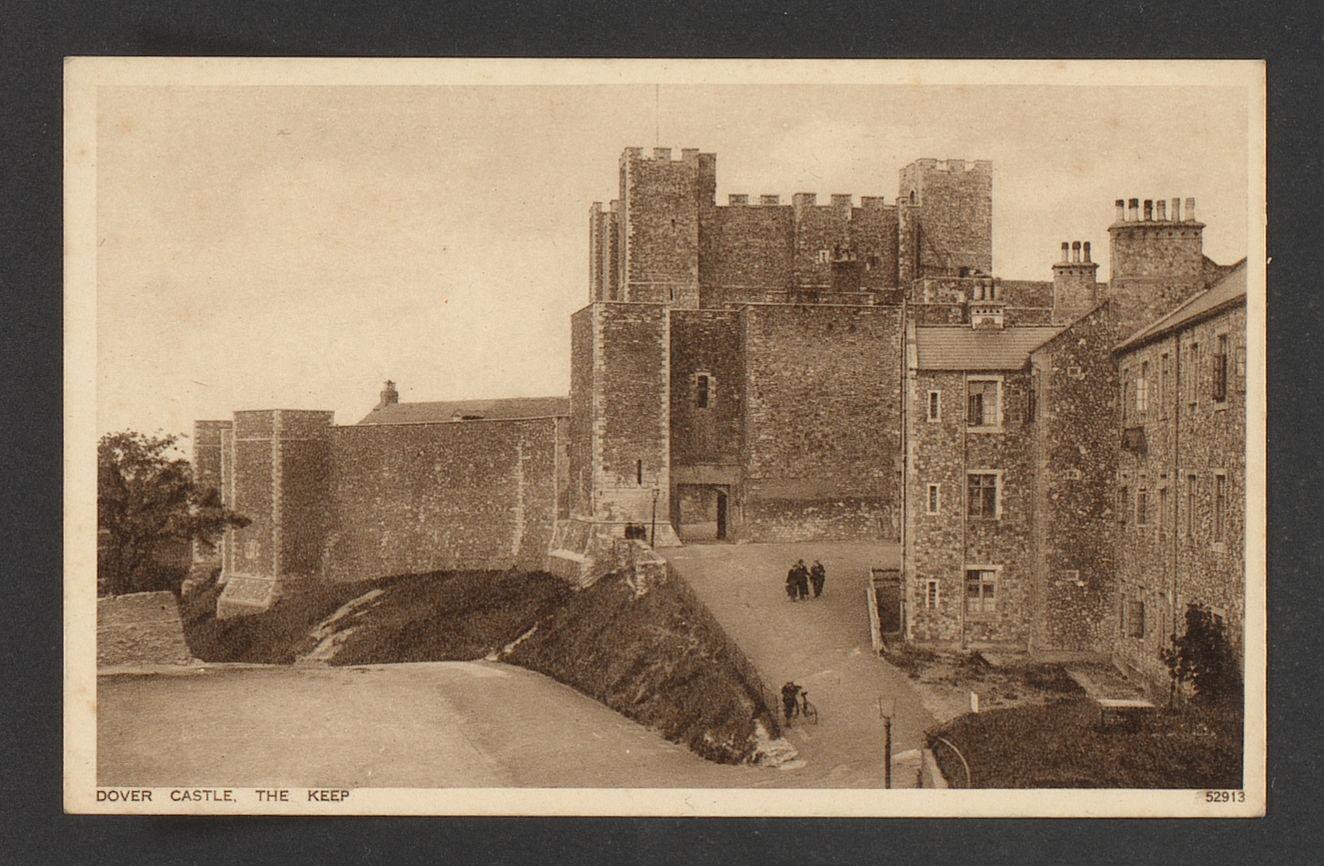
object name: ansichtkaart, prentbriefkaart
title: Dover Castle. The Keep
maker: Anonymous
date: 1905-1934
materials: cardboard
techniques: rotogravure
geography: london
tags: castle